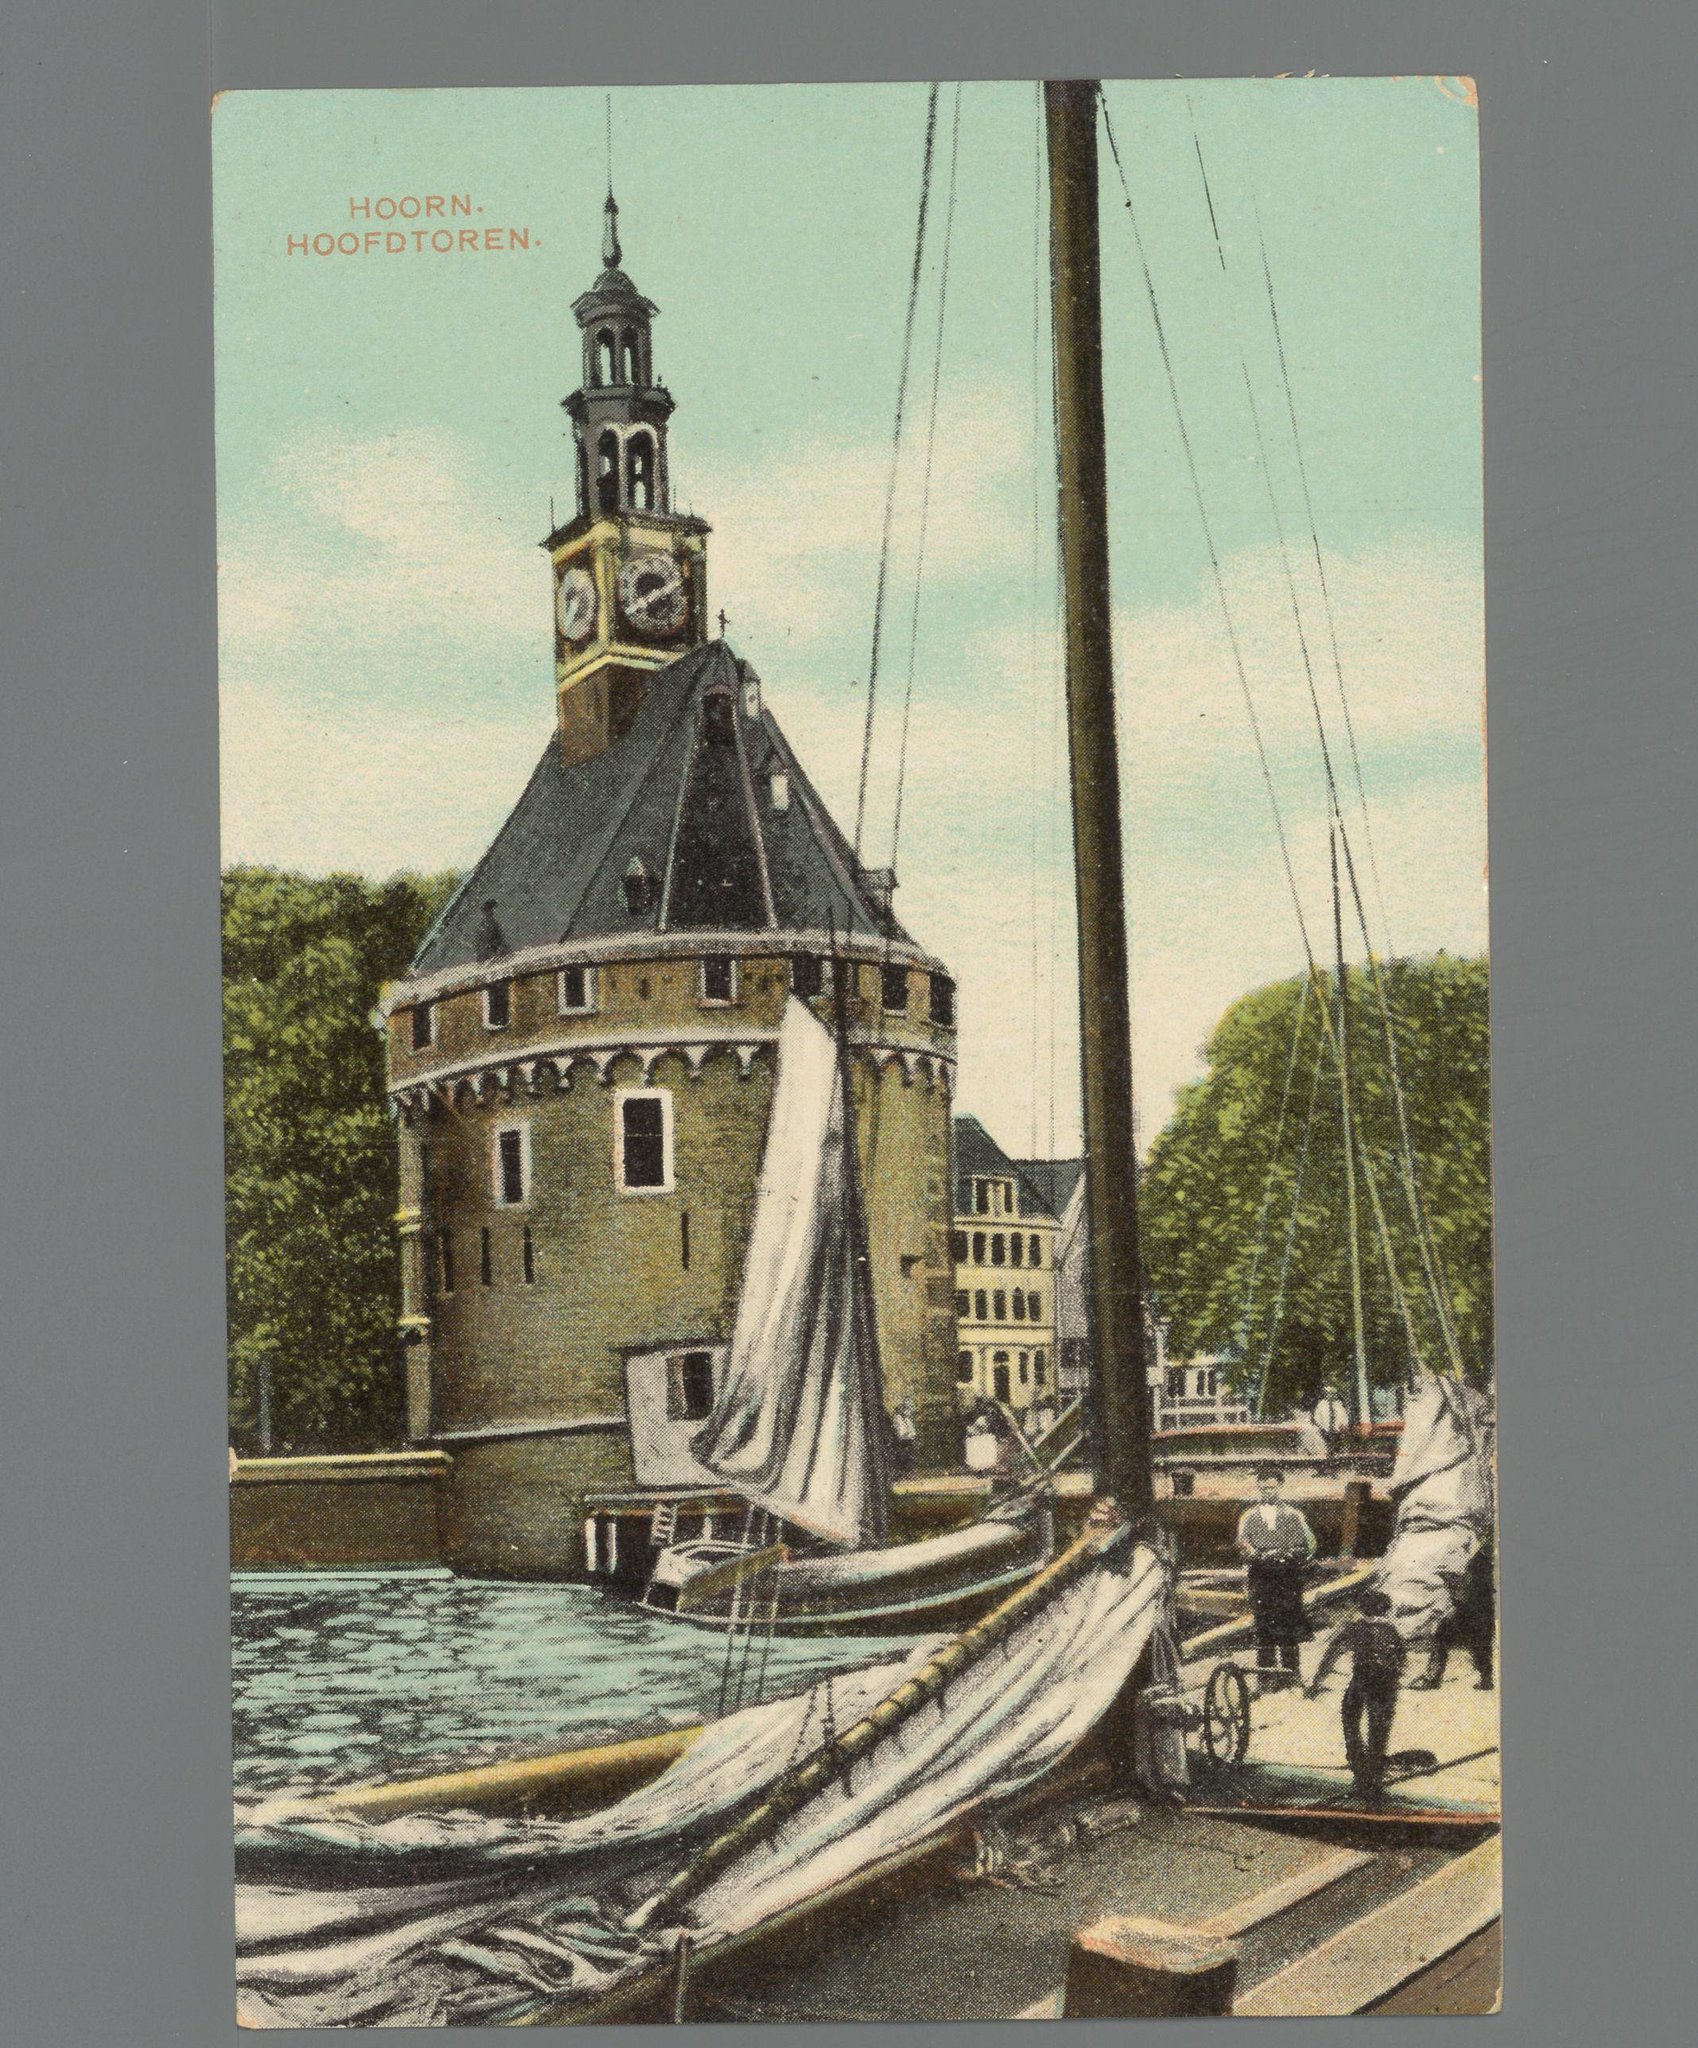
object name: photomechanical print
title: Hoorn. Hoofdtoren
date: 1905-1909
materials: cardboard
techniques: lithograph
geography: hoorn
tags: city-view, and landscape with man-made constructions, sailing-ship, sailing-boat, towers ~ fortified city, hoorn (north holland)